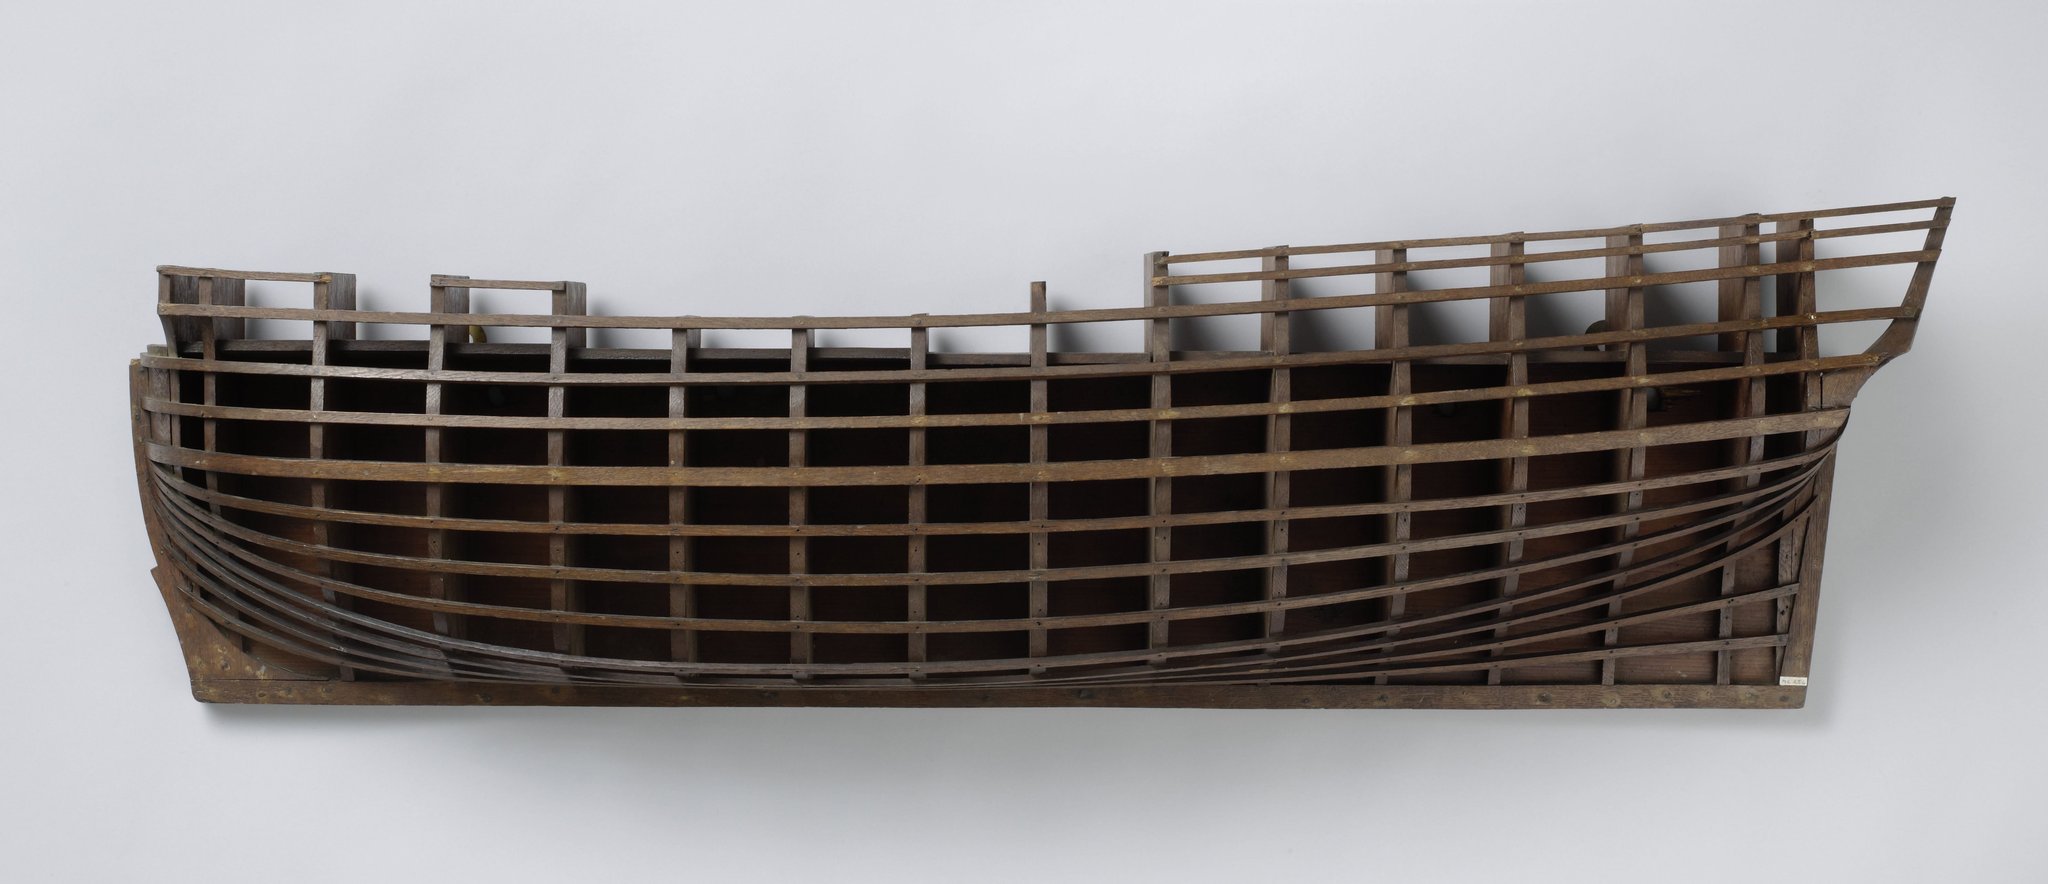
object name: ship model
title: Half Model of a 74-Gun Ship of the Line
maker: Anonymous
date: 1750-1800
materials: wood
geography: netherlands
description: Mallenmodel (bakboord) van een schip, kleine achterplaat. Geen geschutpoorten, geen dekken behalve bakdek, halfdek en bovenkampanje door gillingen aangegeven. Gewrongen spiegel, hol wulf, geen details van hek of zijgalerij; geen roer. Zeeg naar achteren oplopend. De senten tussen het onderste berghout en het reehout zijn breder dan die van het onderwaterschip. Rondspant, geveegd achterschip.